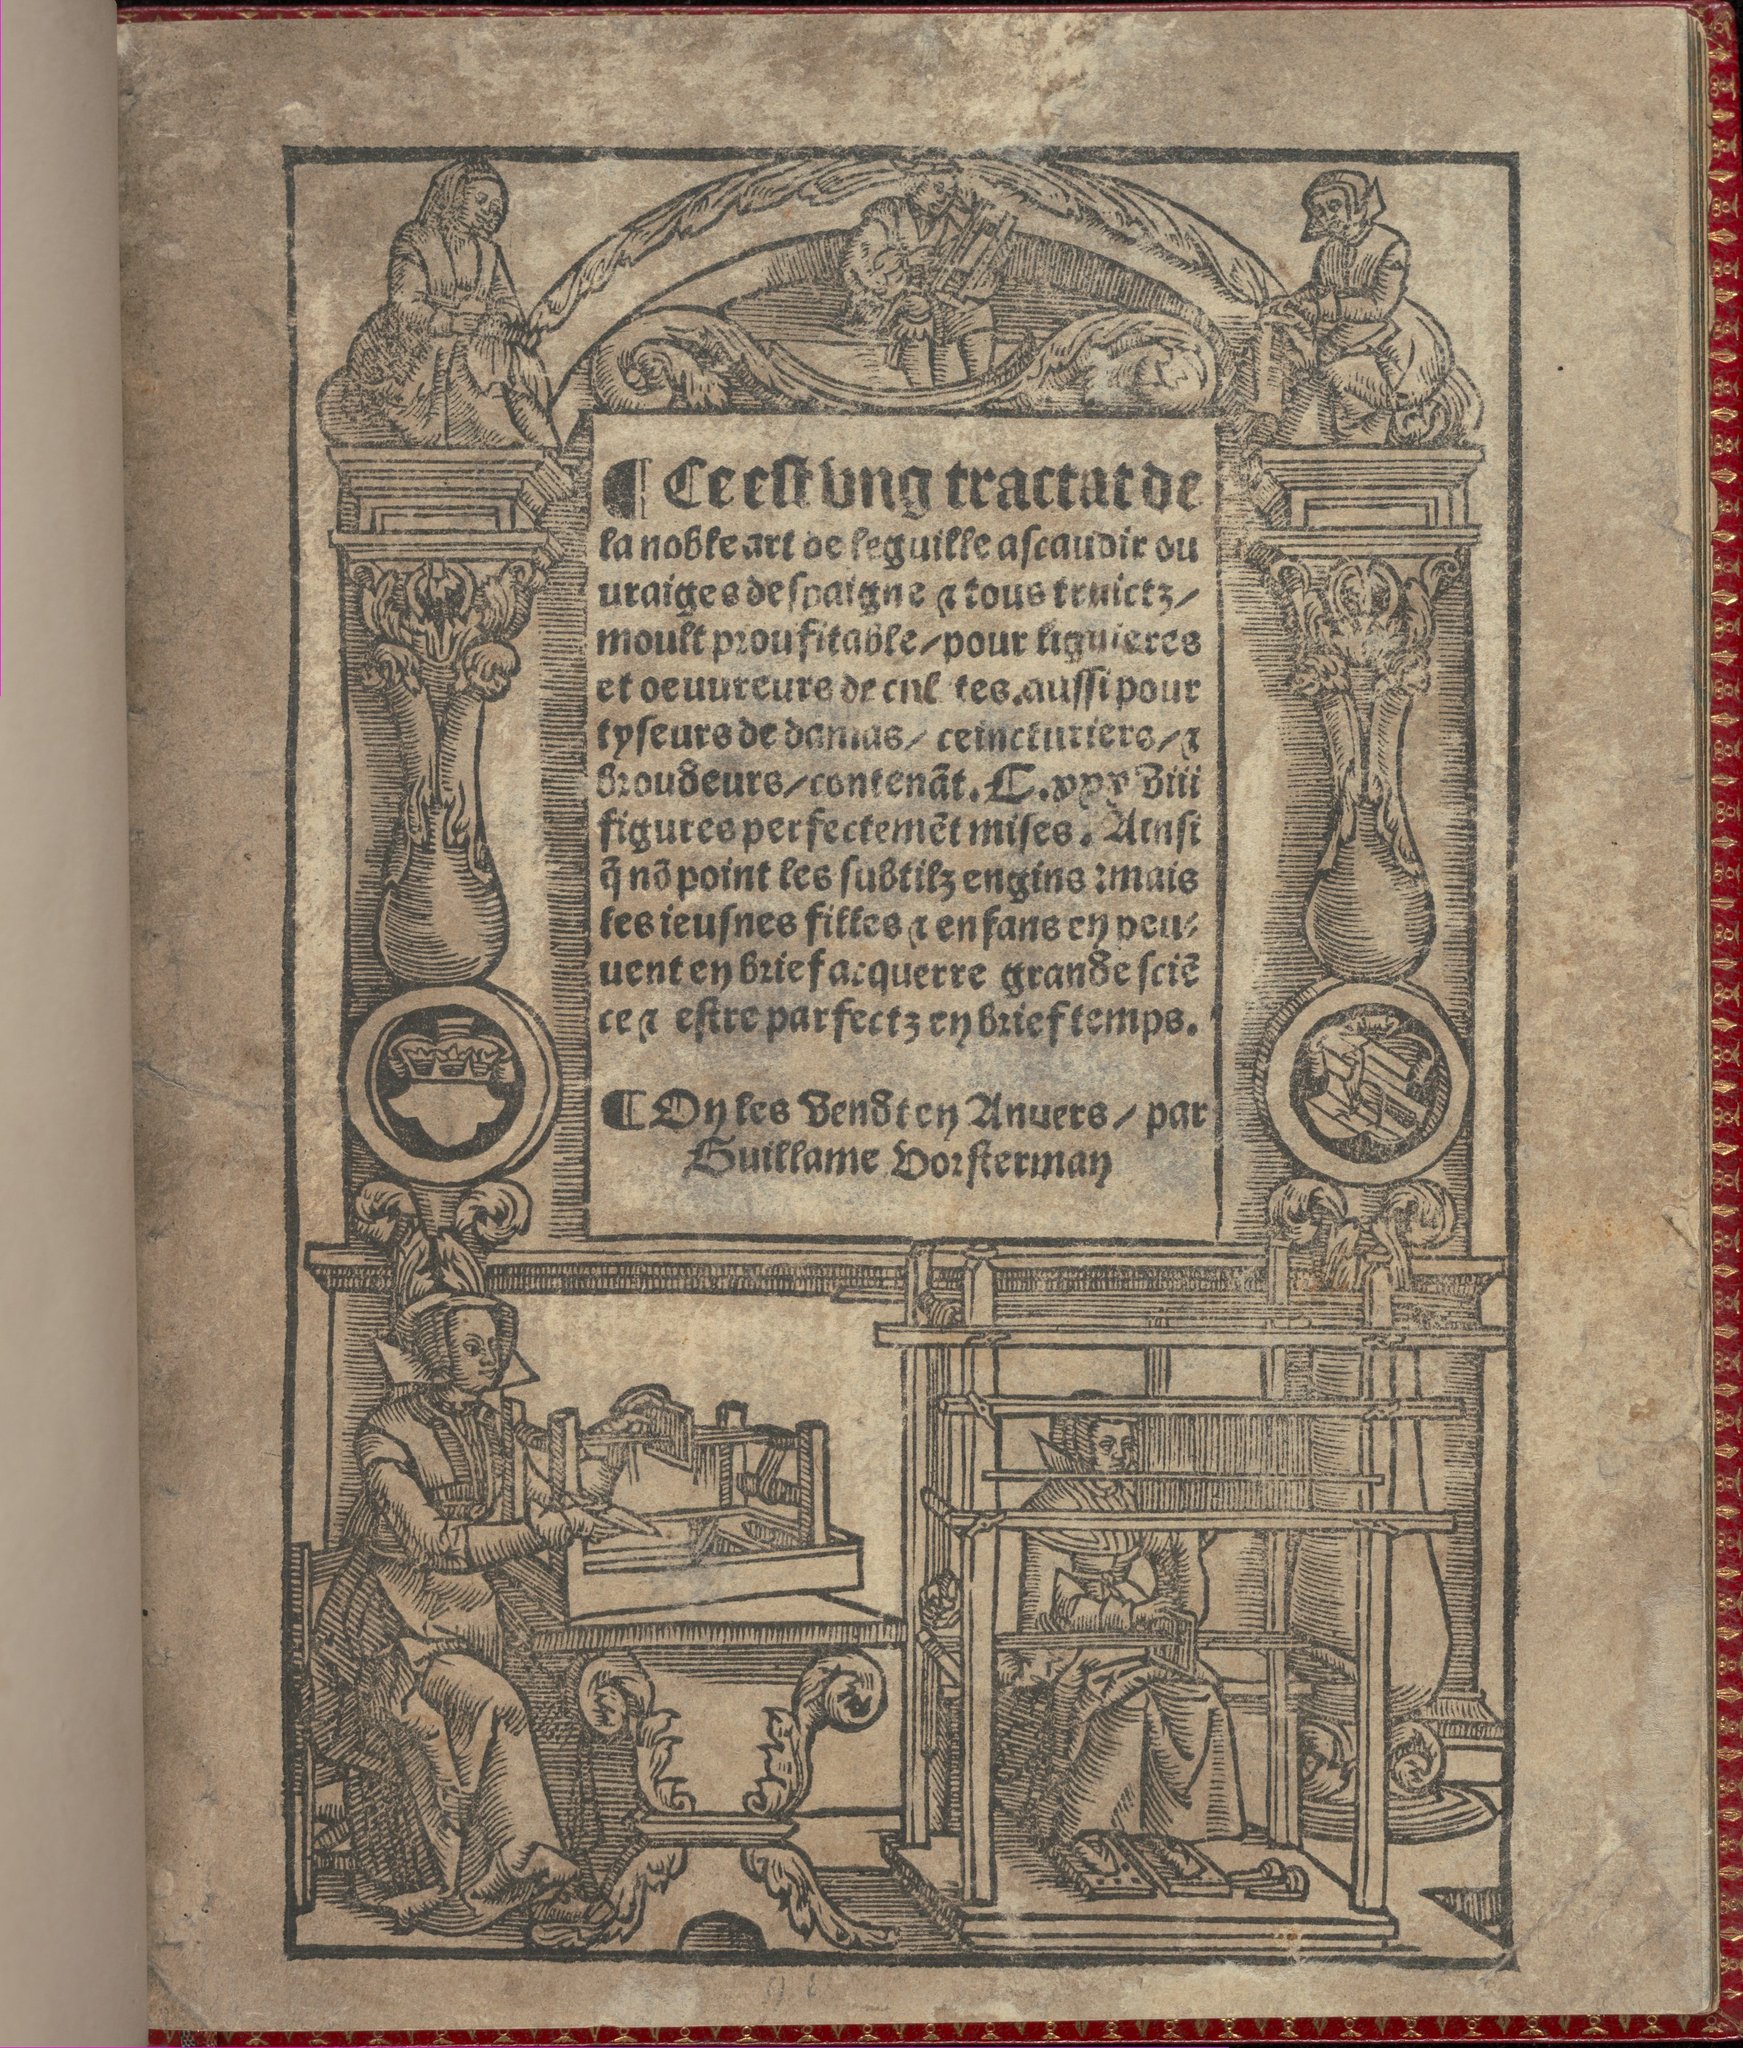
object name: book print ornament architecture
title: Ce est ung tractat de la noble art de leguille ascavoir ouvraiges de spaigne...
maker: willem vosterman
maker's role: printer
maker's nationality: netherlandish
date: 1527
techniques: woodcut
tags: men,women